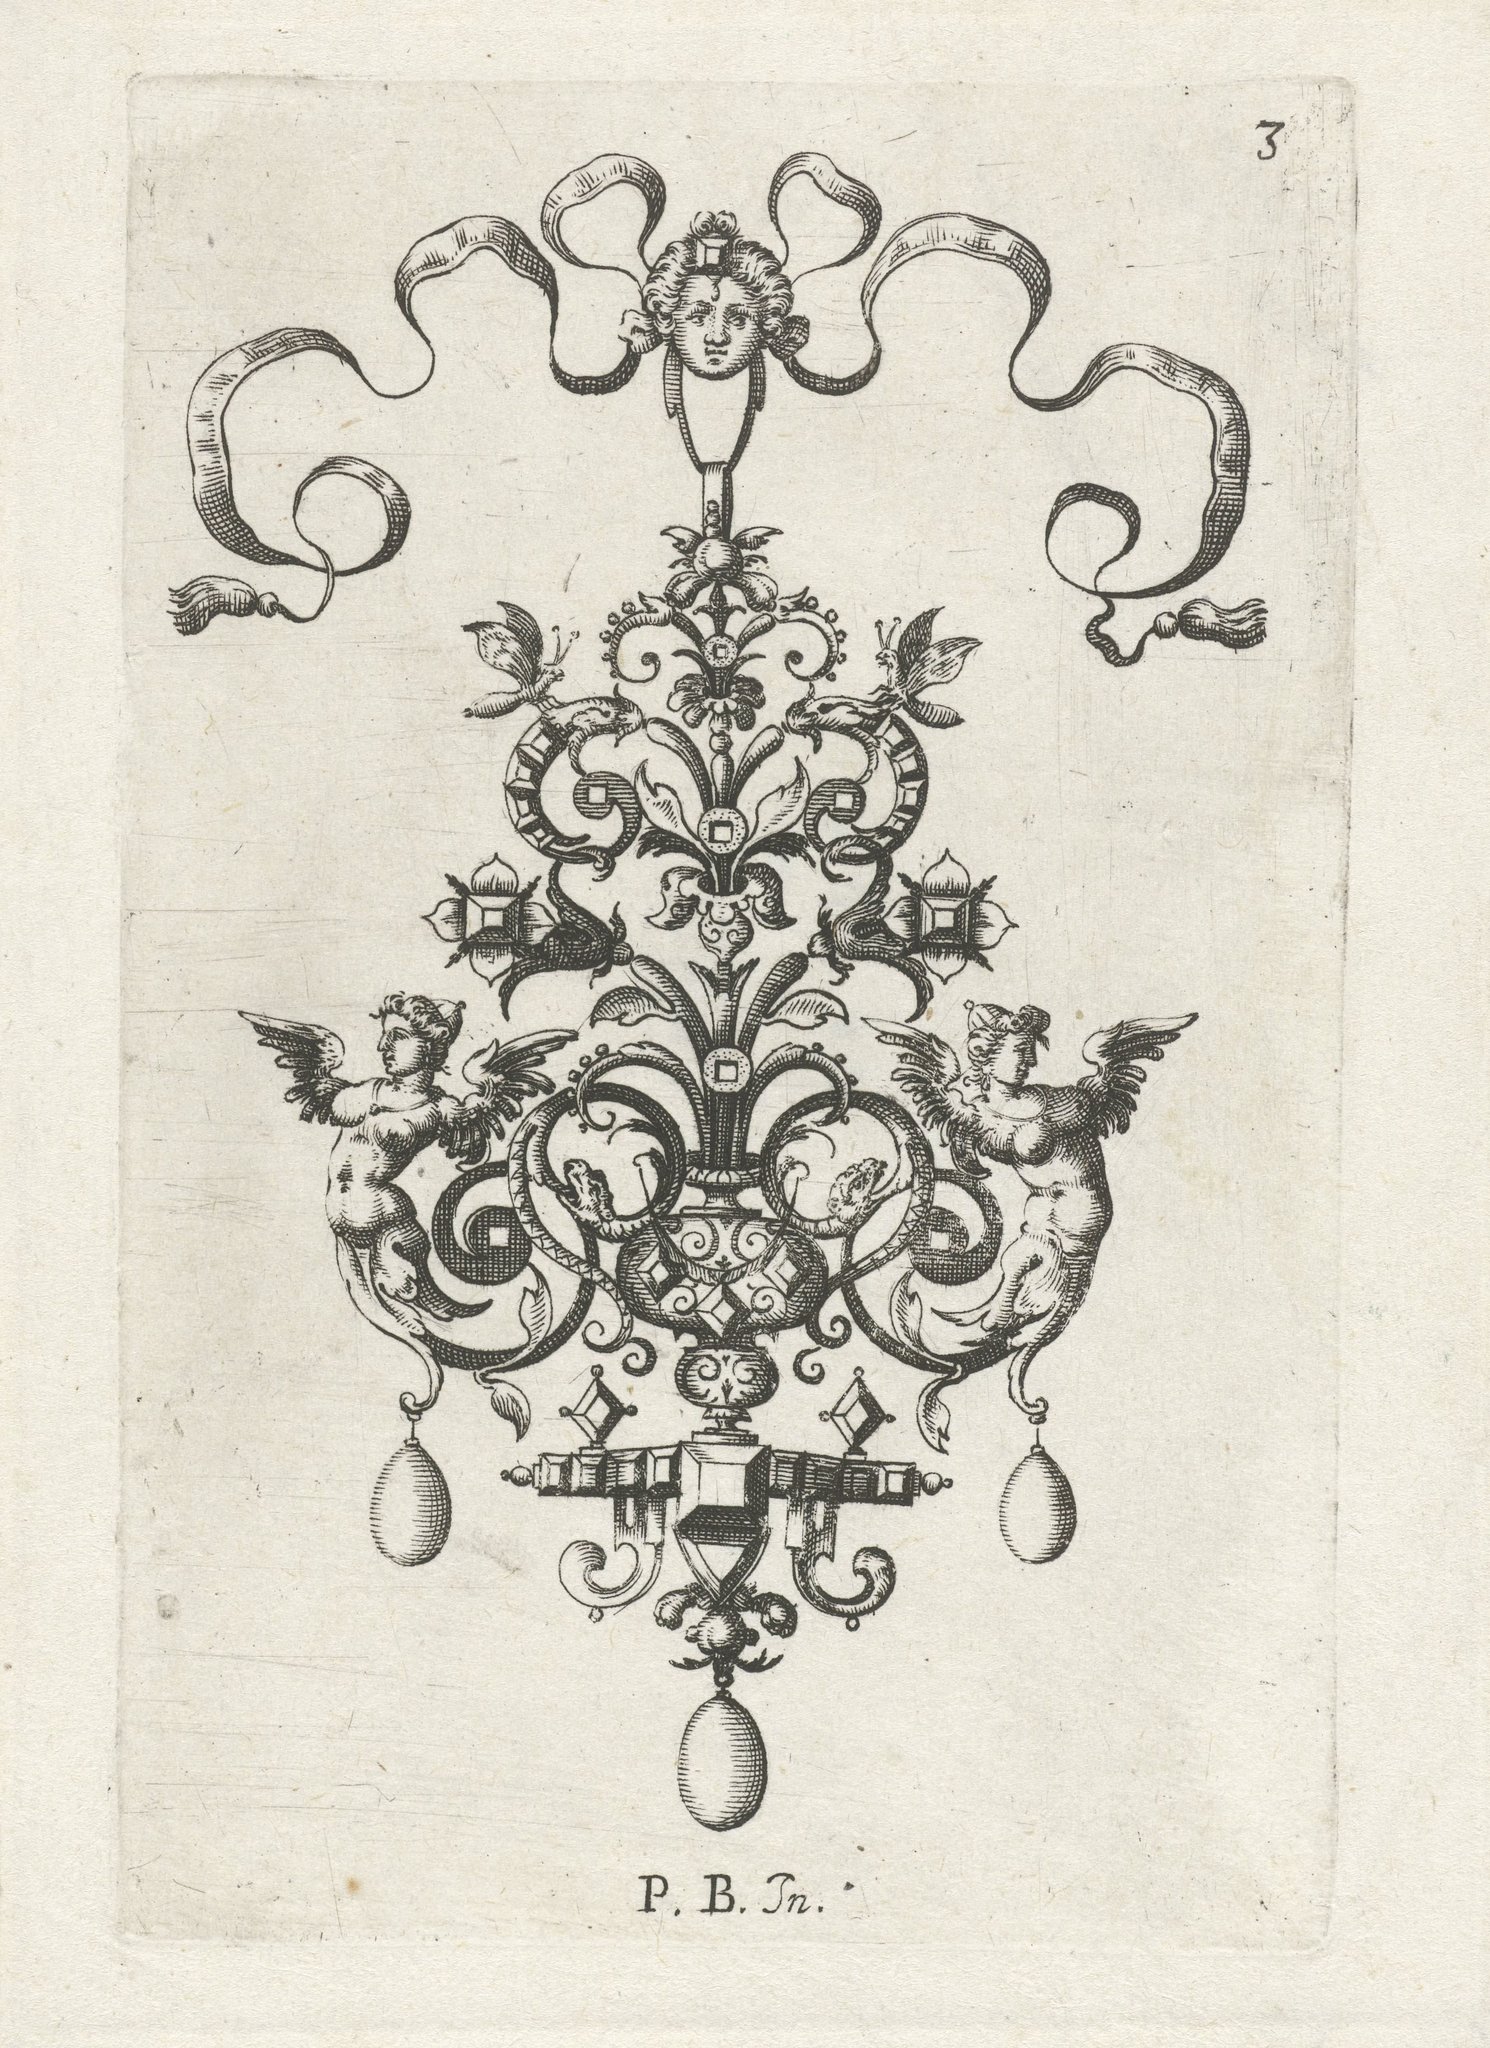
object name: ornament print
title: Pendeloque. In den r.b.: 3. Onderaan in het midden P.B. In.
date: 1571-1639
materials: paper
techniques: engraving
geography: germany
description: Hanger met een bloemenvaas tussen de bovenlichamen van twee gevleugelde vrouwen. Aan de hanger hangen drie parels. De hanger is opgehangen aan een mascaron met linten. Blad naar een serie, bestaande uit een titelblad en 5 bladen.